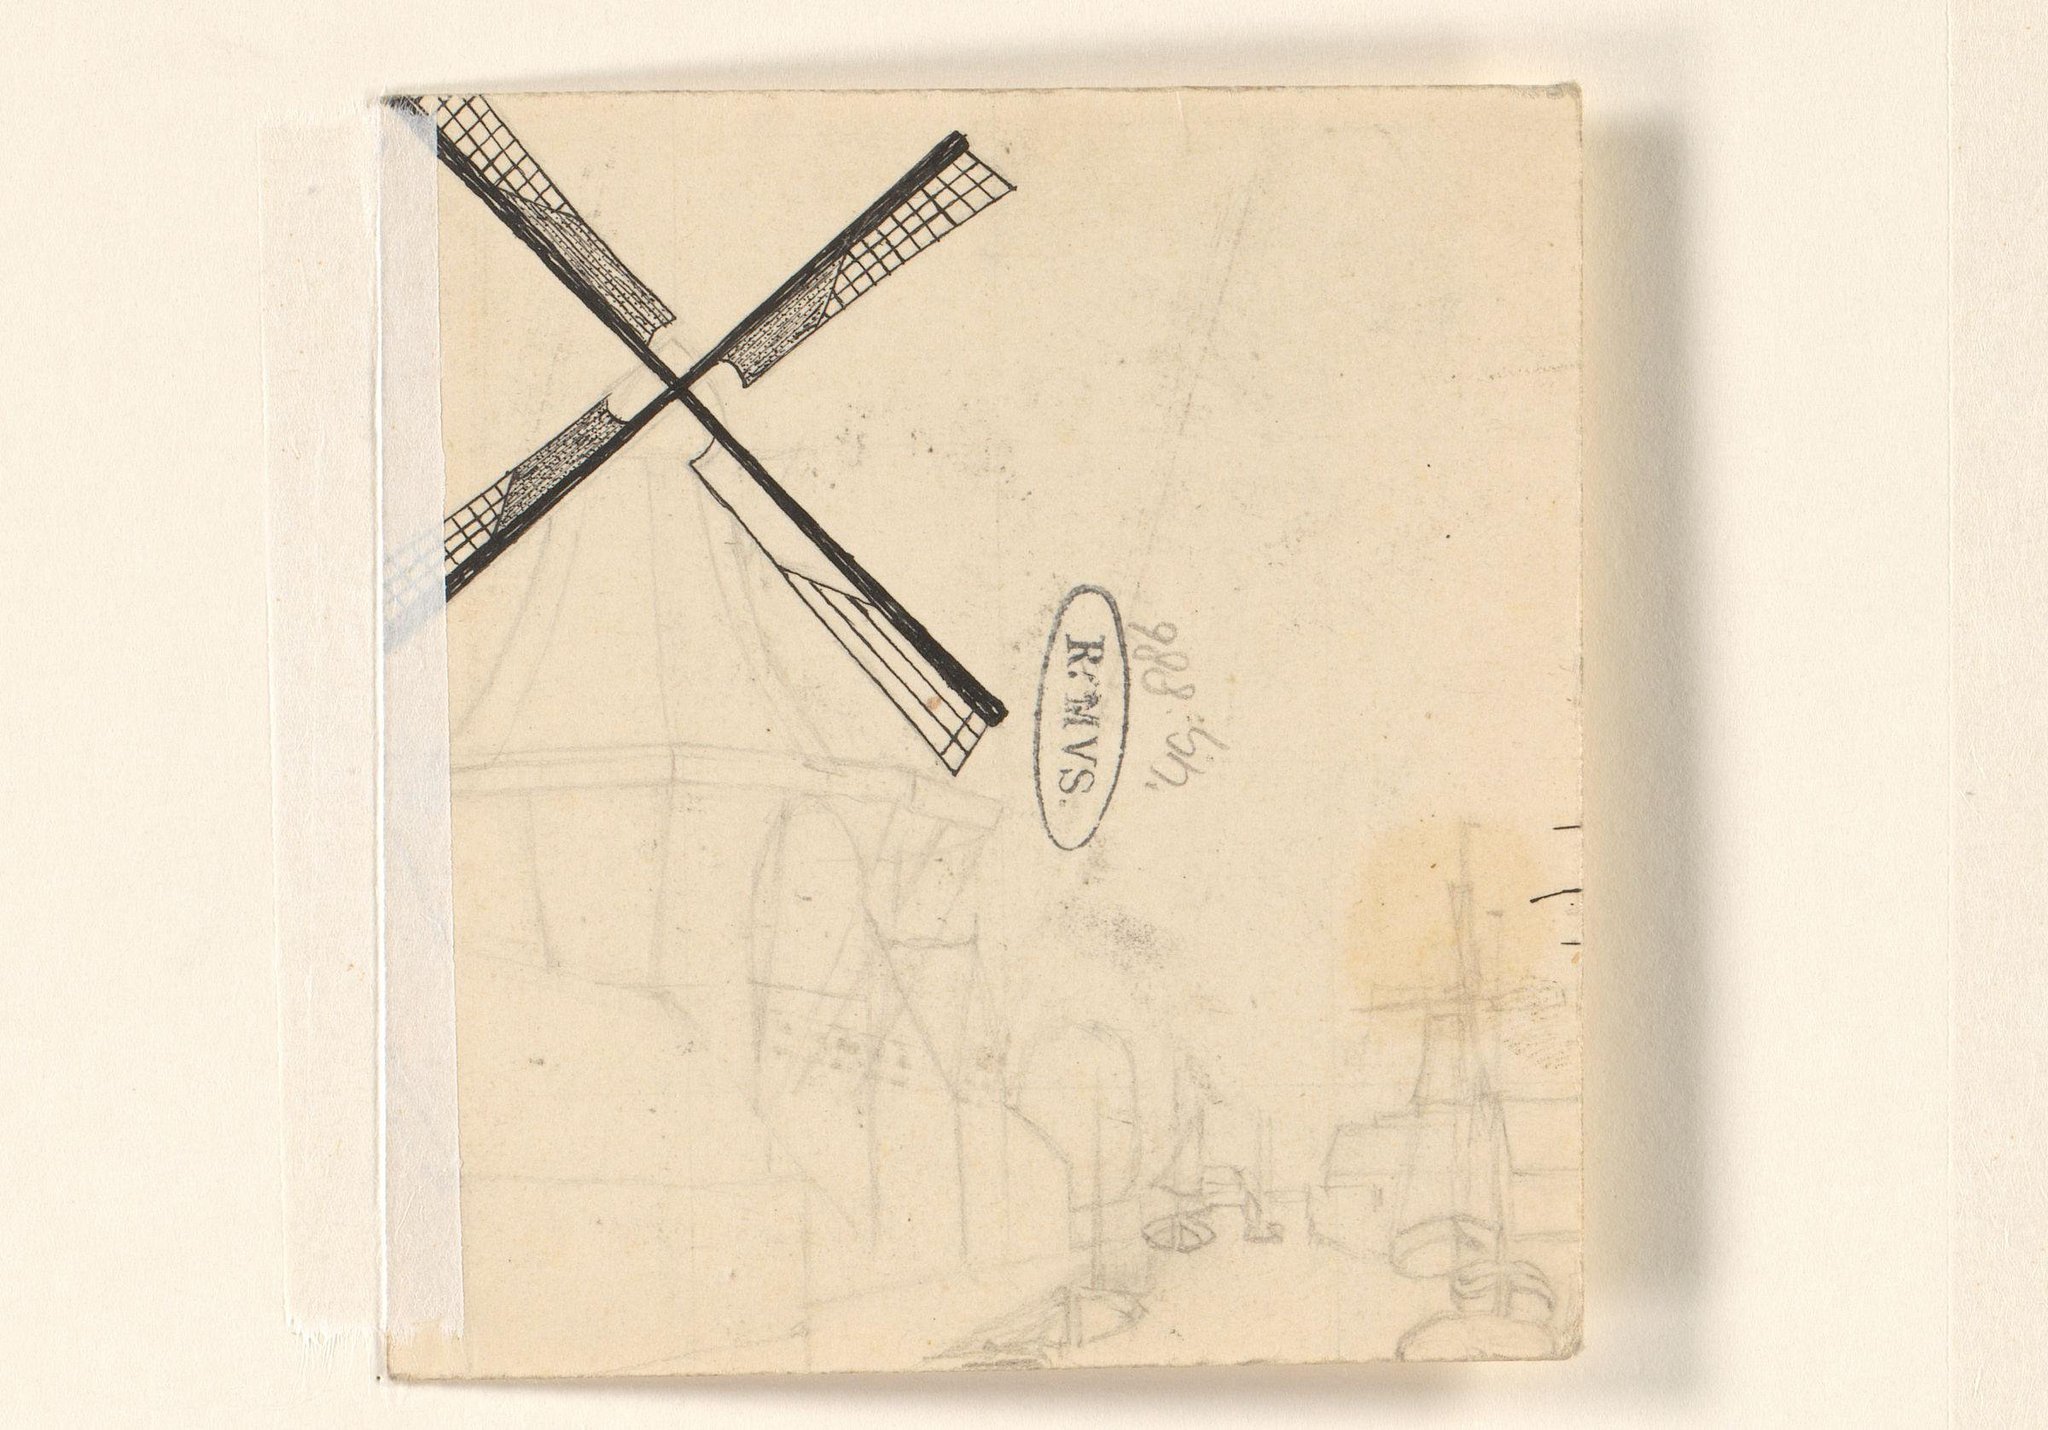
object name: drawing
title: Twee molens aan een vaart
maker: august allebé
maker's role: draughtsman, print maker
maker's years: 1838-1927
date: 1848-1927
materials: ink, paper, pencil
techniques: pen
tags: canal, windmill